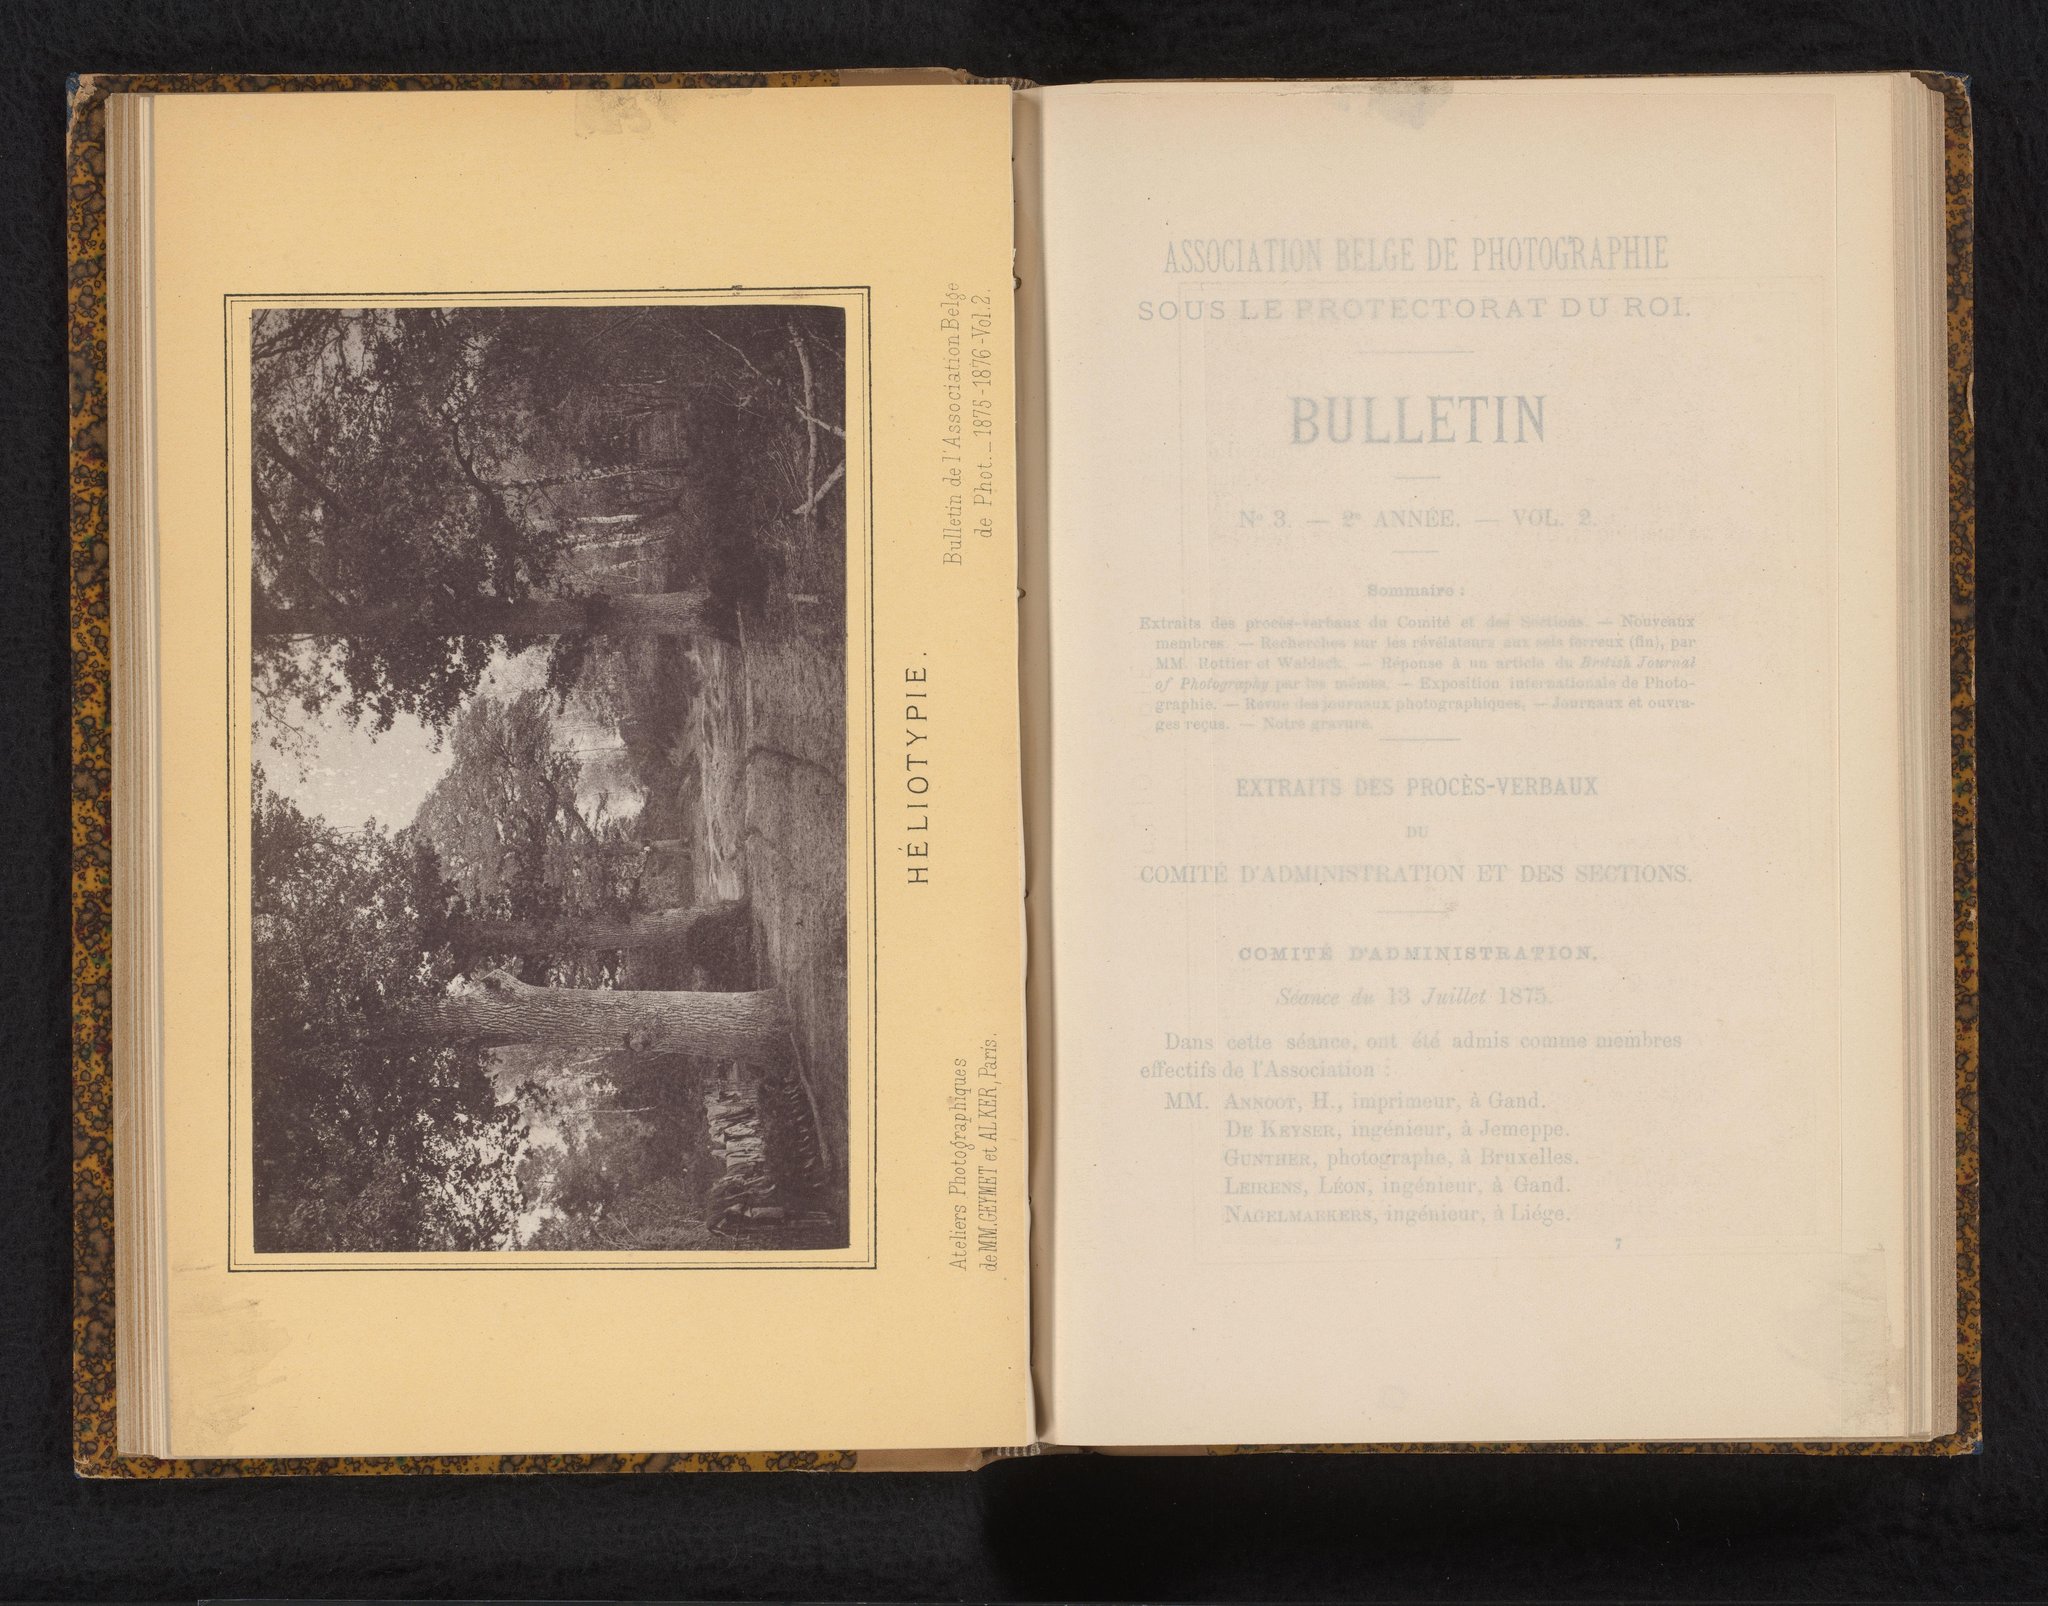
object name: photomechanical print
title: Boslandschap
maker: théophile geymet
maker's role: printer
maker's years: 1826-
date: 1875-1876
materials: cardboard, paper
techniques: heliotype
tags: waterfall, forest, wood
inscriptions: inscription: ‘Héliotypie’